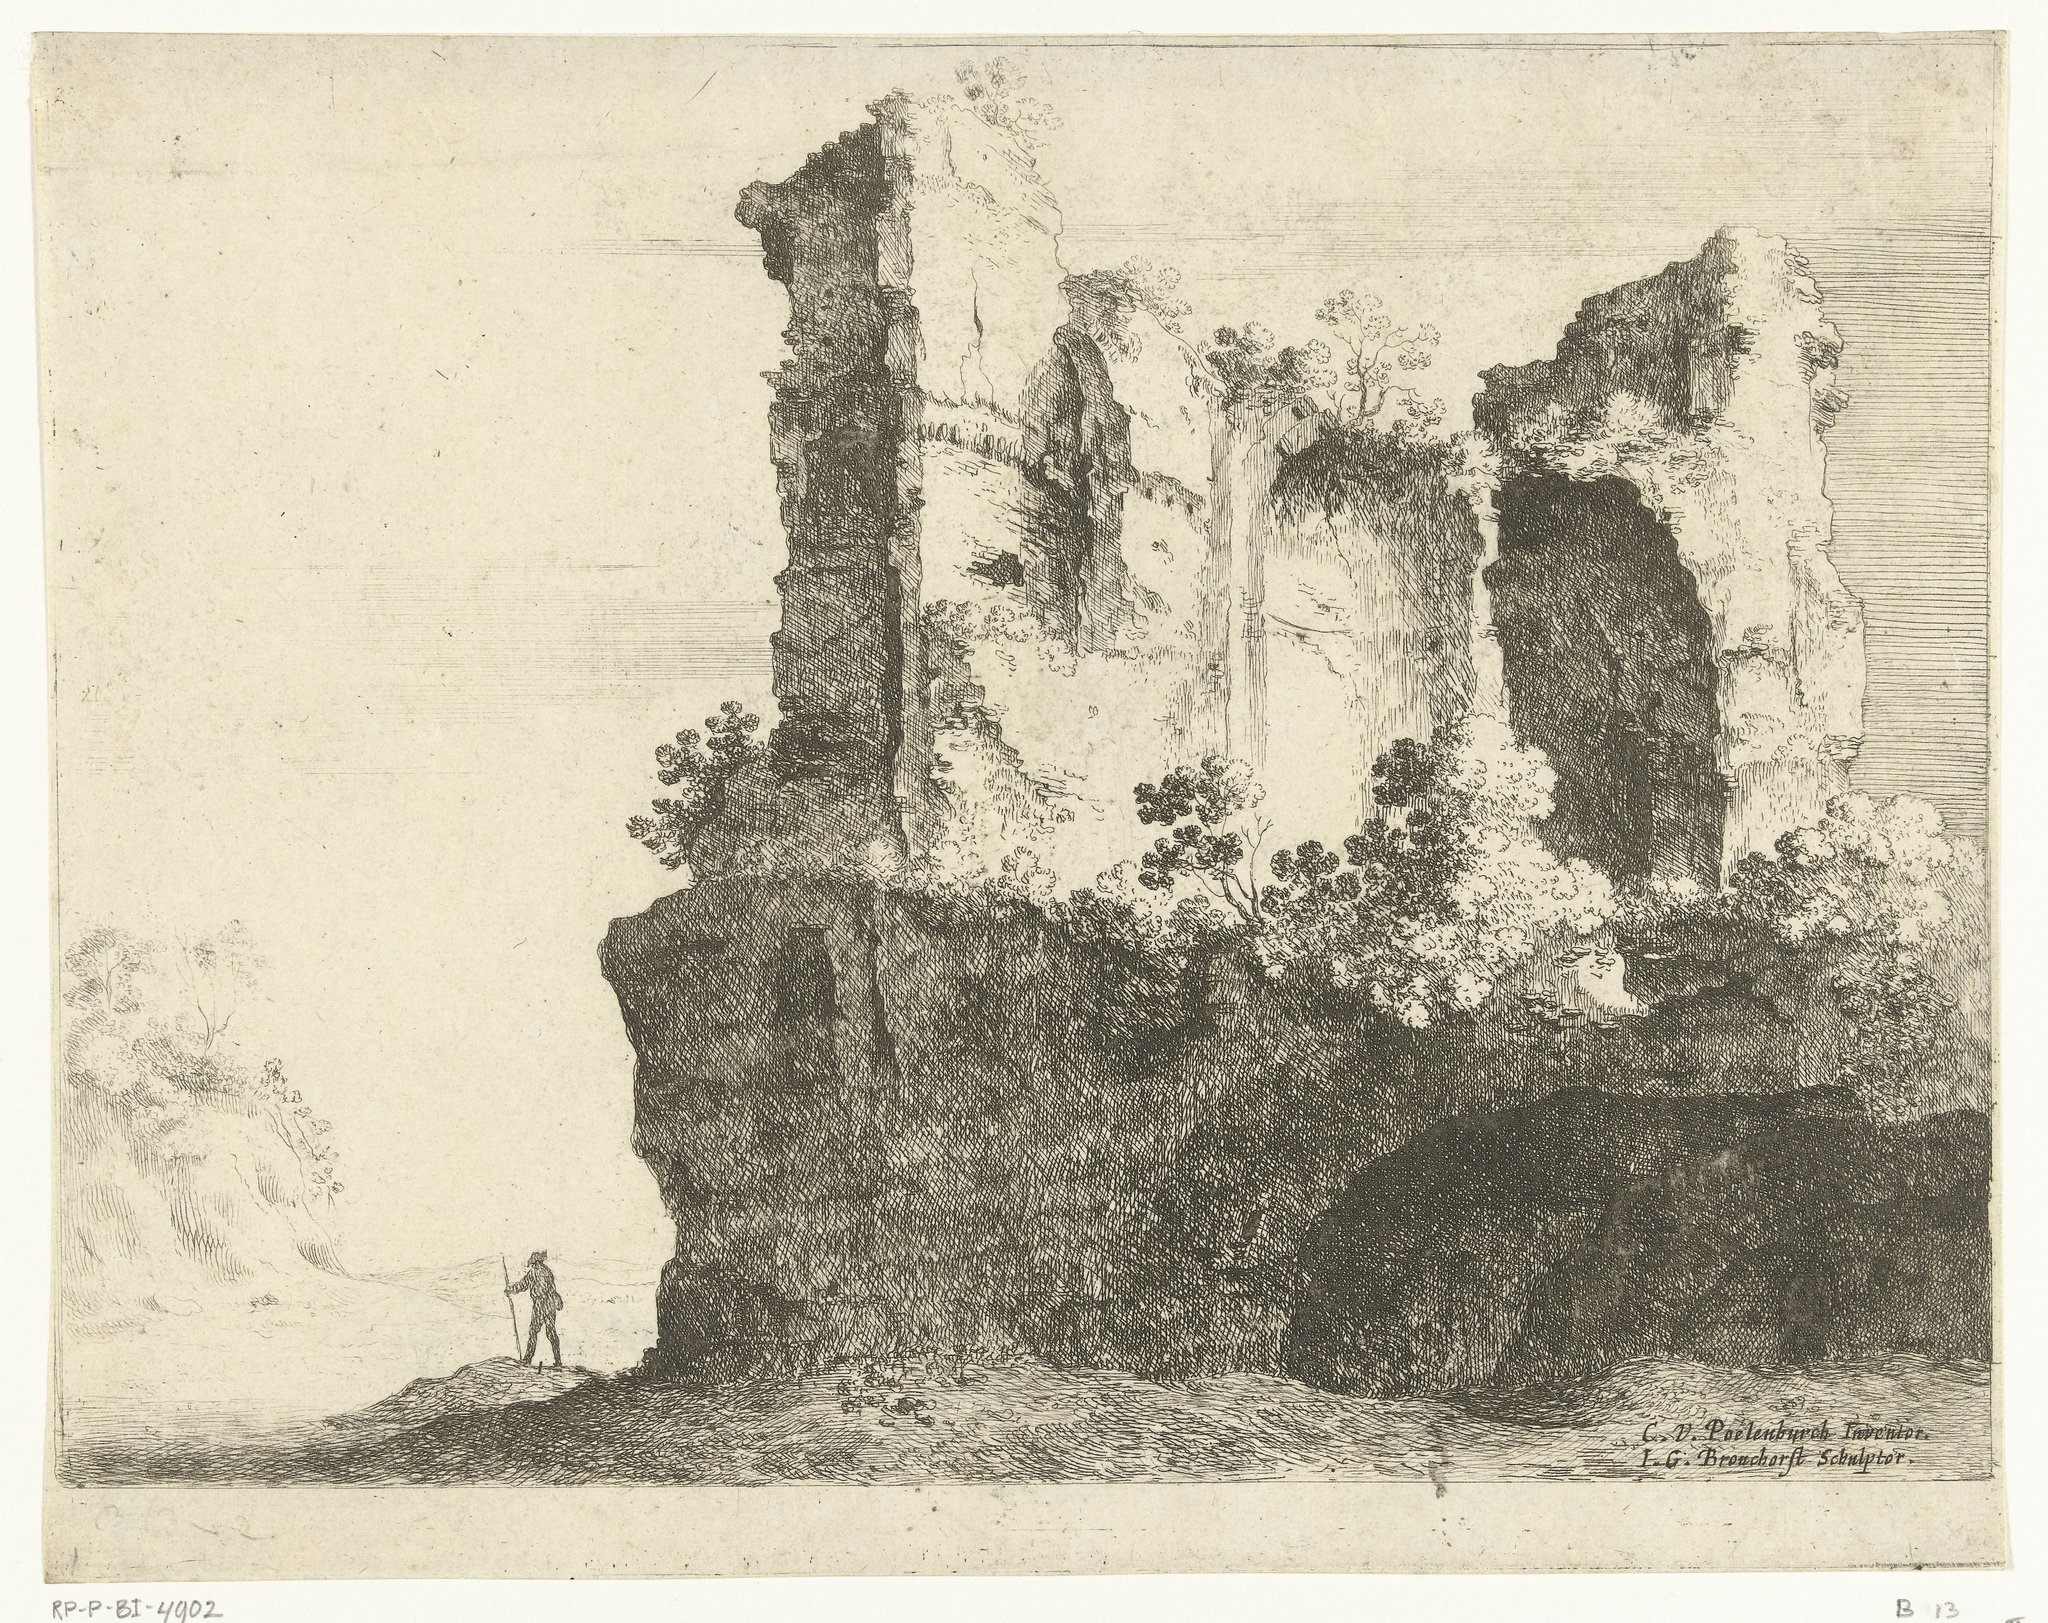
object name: print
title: Ruïnes van de Trofeeën van Marius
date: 1613-1661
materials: paper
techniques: etching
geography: netherlands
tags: ruin of a building ~ architecture, landscape with ruins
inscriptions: collector's mark: Lugt 2228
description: De ruïnes van het Nymphaeum Alexandri waren vroeger bekend als de Trofeeën van Marius welke de functie hadden van een monumentale fontein op de plaats van het tegenwoordige Piazza Vittorio Emanuel II te Rome, zie http://www.romanaqueducts.info/webteksten/framewvdw.htm. In Hollstein en Bartsch worden de ruïnes de Trofeeën van Marius genoemd. Prent naar ontwerp van Cornelis van Poelenburch. Prent uit serie van negen prenten met Romeinse ruïnes.